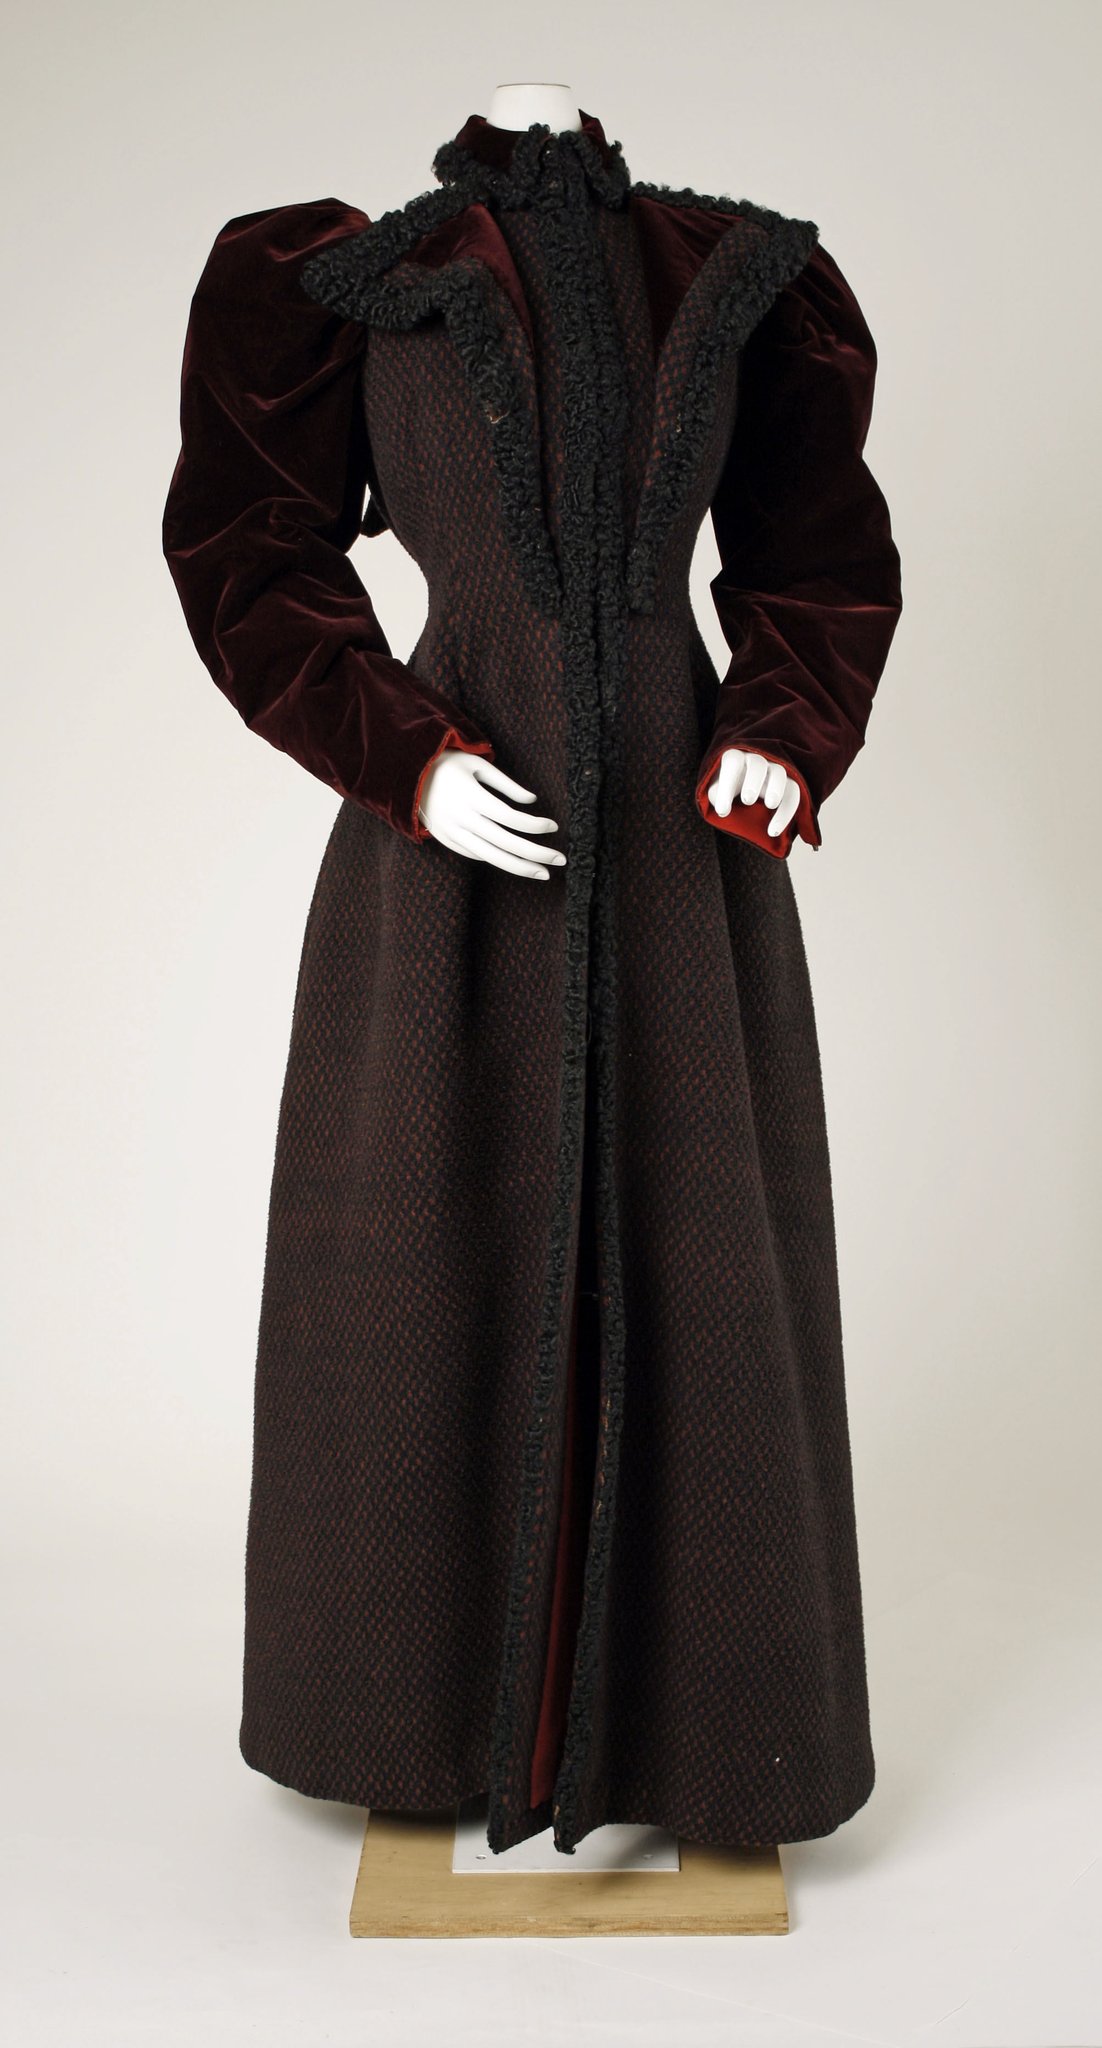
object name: coat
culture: american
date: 1893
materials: silk, wool